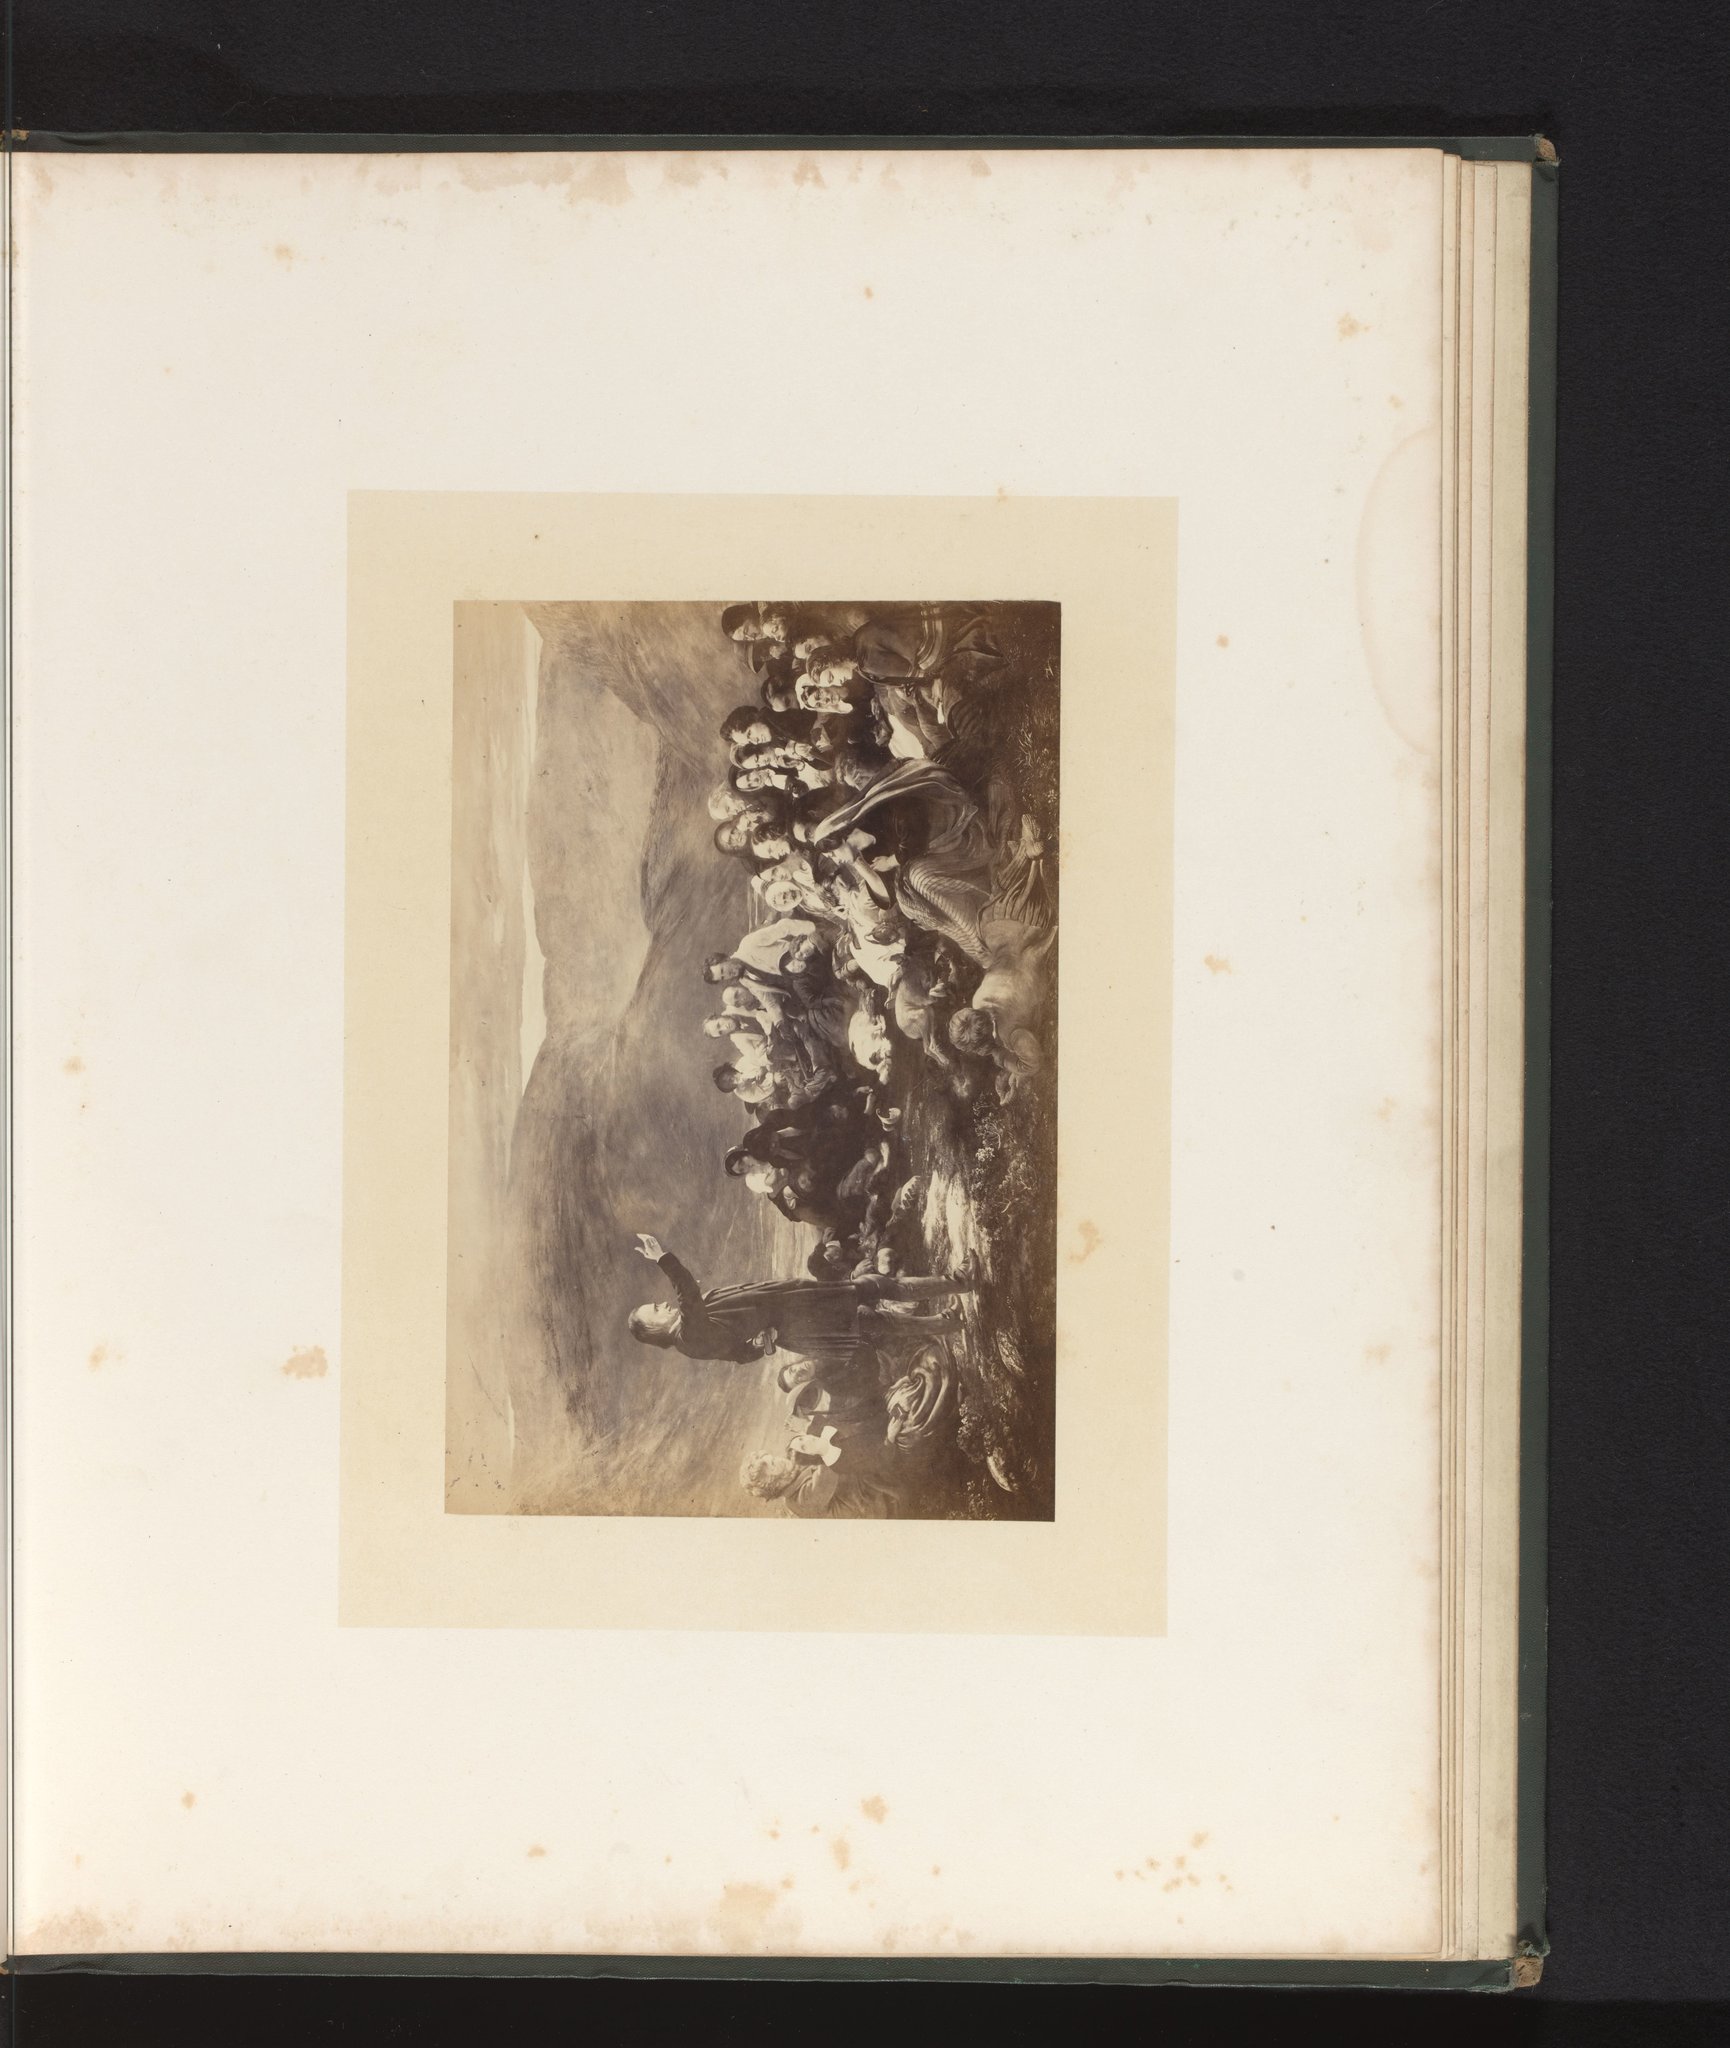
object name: page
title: Fotoreproductie van Sabbath in the Glen door Sir George Harvey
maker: thomas annan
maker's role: fotograaf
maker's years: 1829-1887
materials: photographic support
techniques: albumen print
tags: sabbath ~ jewish religion, meeting, assembly - aa - in the open air